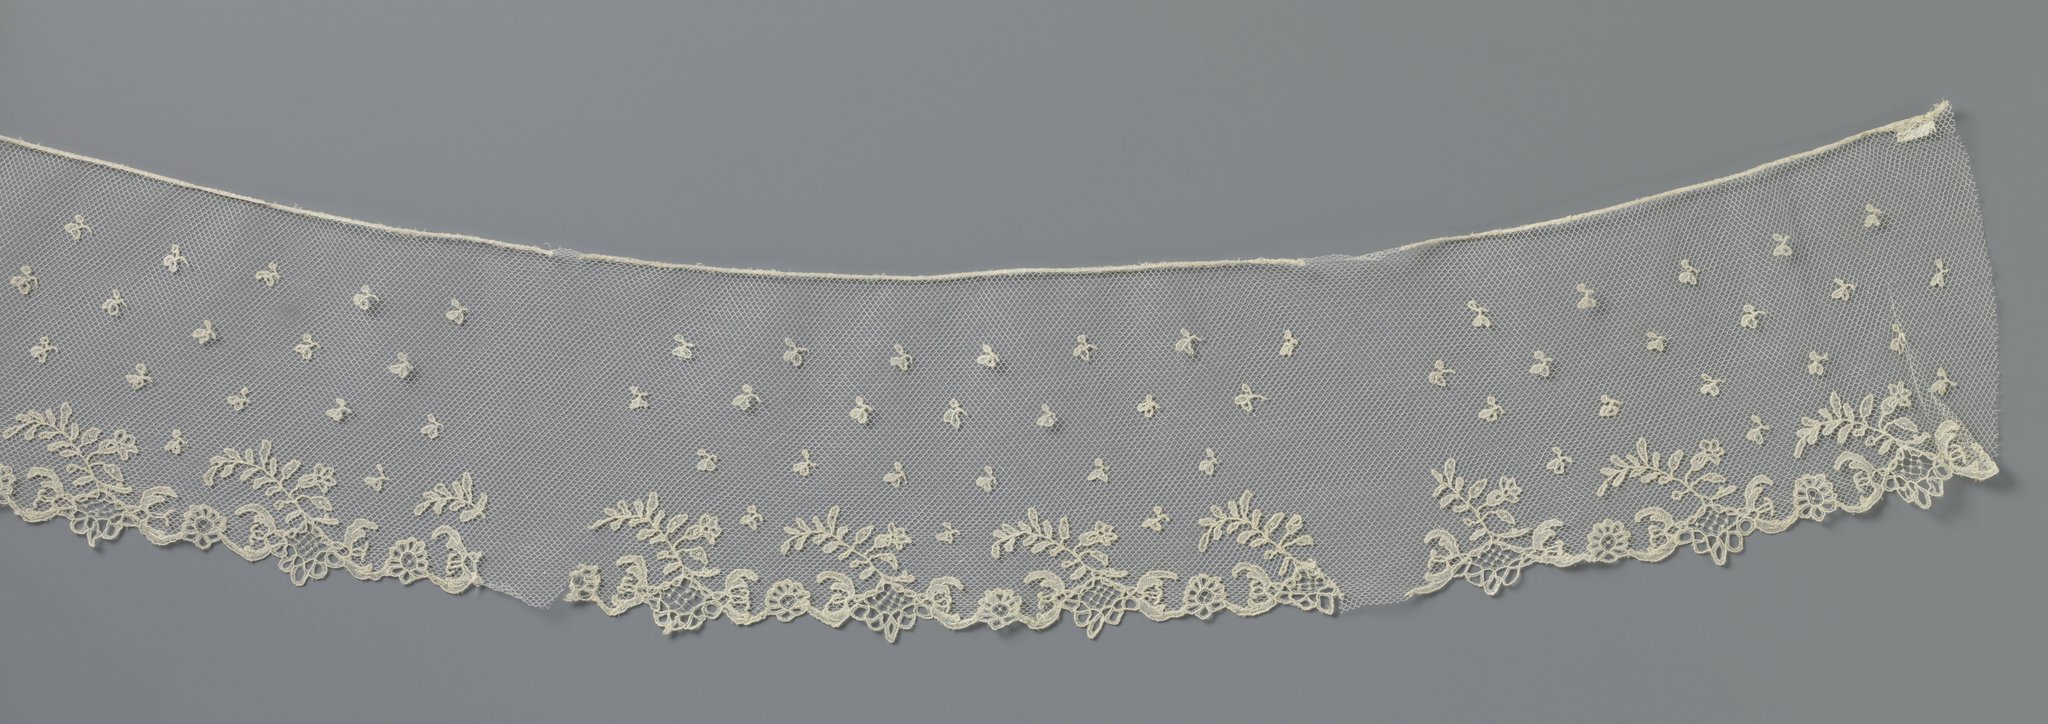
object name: strip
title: Strook applicatiekant met naar links wuivende blaadjes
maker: Anonymous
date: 1840-1850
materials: linen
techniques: lace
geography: england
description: Strook naturelkleurige applicatiekant: naaldkant geappliceerd op machinale tule. Dit type kant staat ook bekend onder de naam: point d'Angleterre. Tweederde deel is bezaaid met blaadjes, een derde deel bestaat uit een symmetrische schulprand van een rozetje en een open medaillon, verbonden door sikkelvormige blaadjes. Uit die medaillons groeit een naar links wuivend, ingesneden blad.